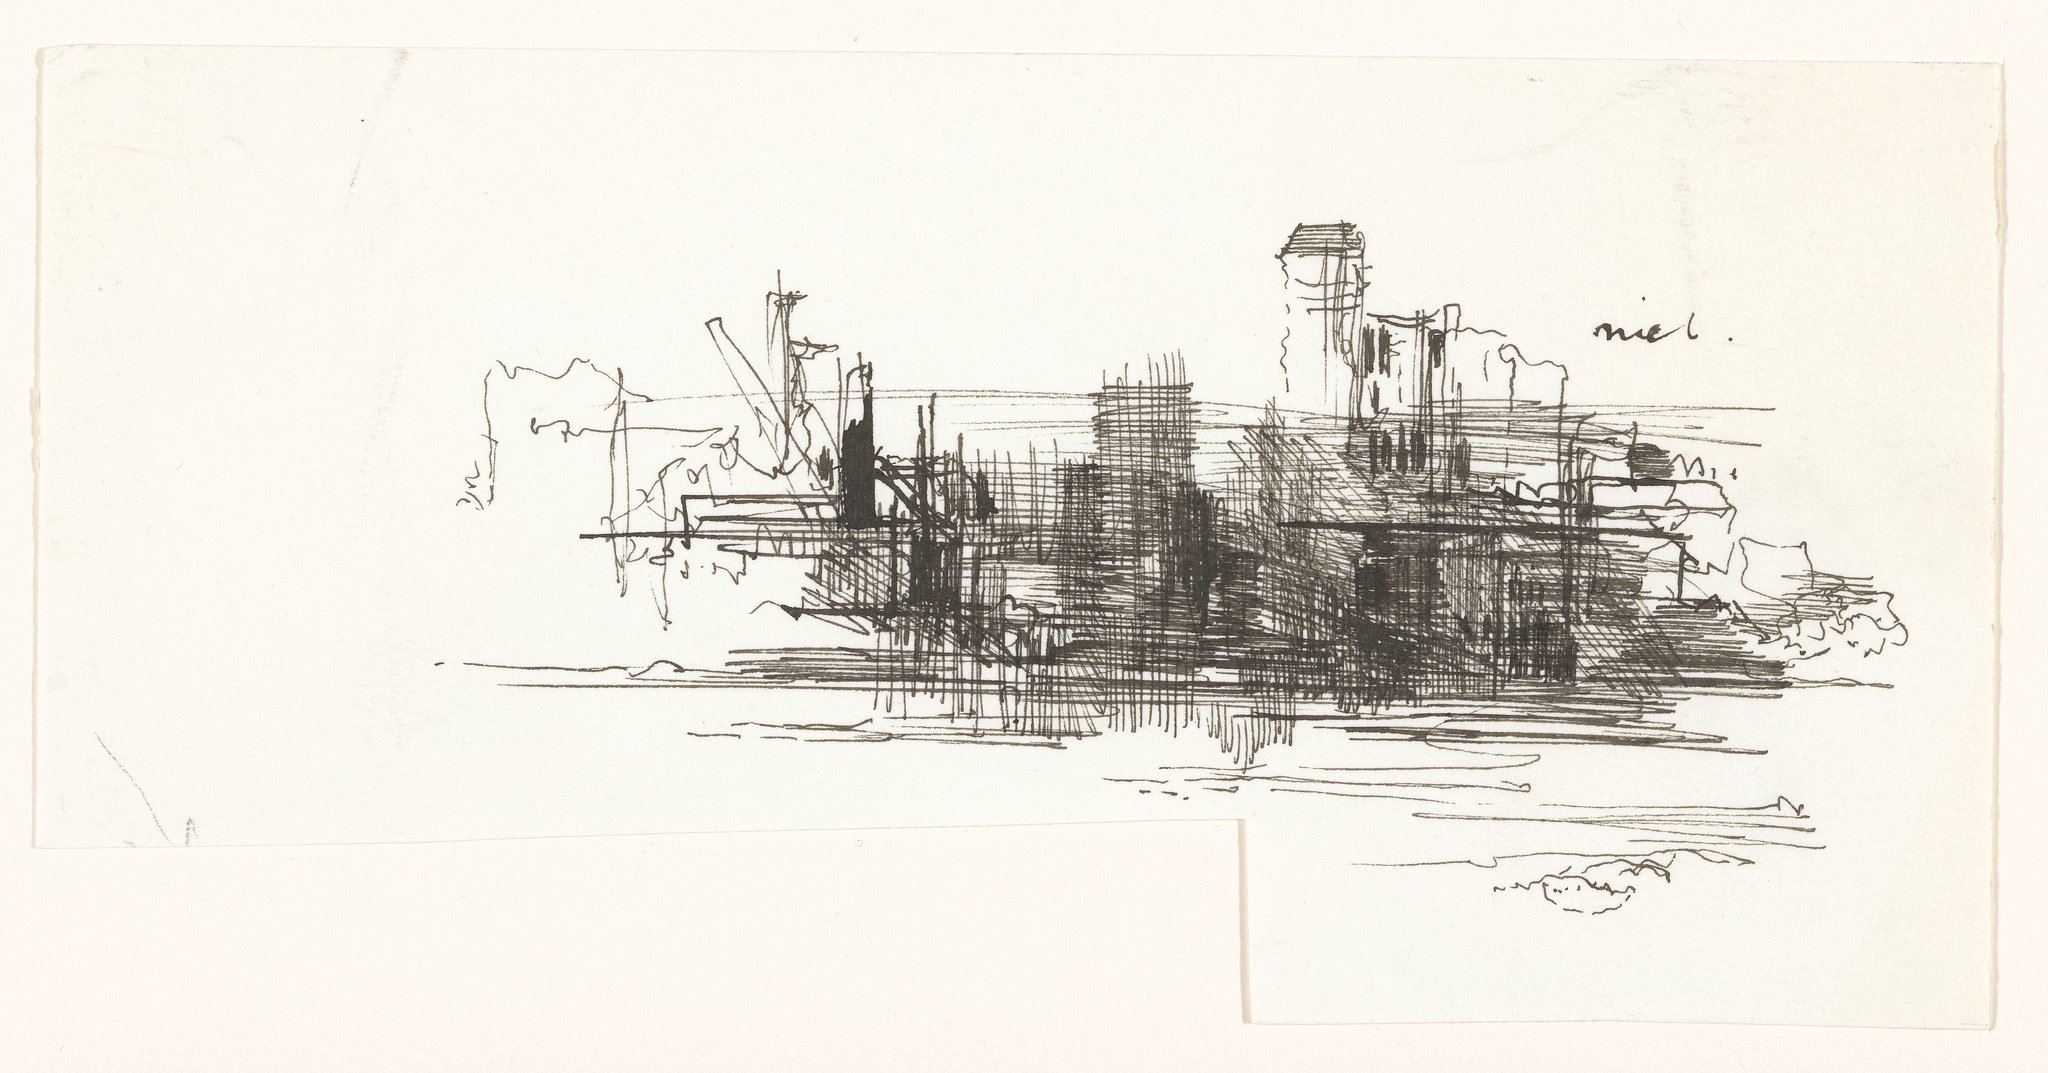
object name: drawing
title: Stadsgezicht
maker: dirkje kuik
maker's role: print maker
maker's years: 1929-2008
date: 1945-2005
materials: ink, paper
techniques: pen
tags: city-view in general; 'veduta' - ii - ideal city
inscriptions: inscription: ‘niet.’, inscription: ‘marge tek. [?]’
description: Geabstraheerd stadgezicht met verticale en horizontale lijnen.